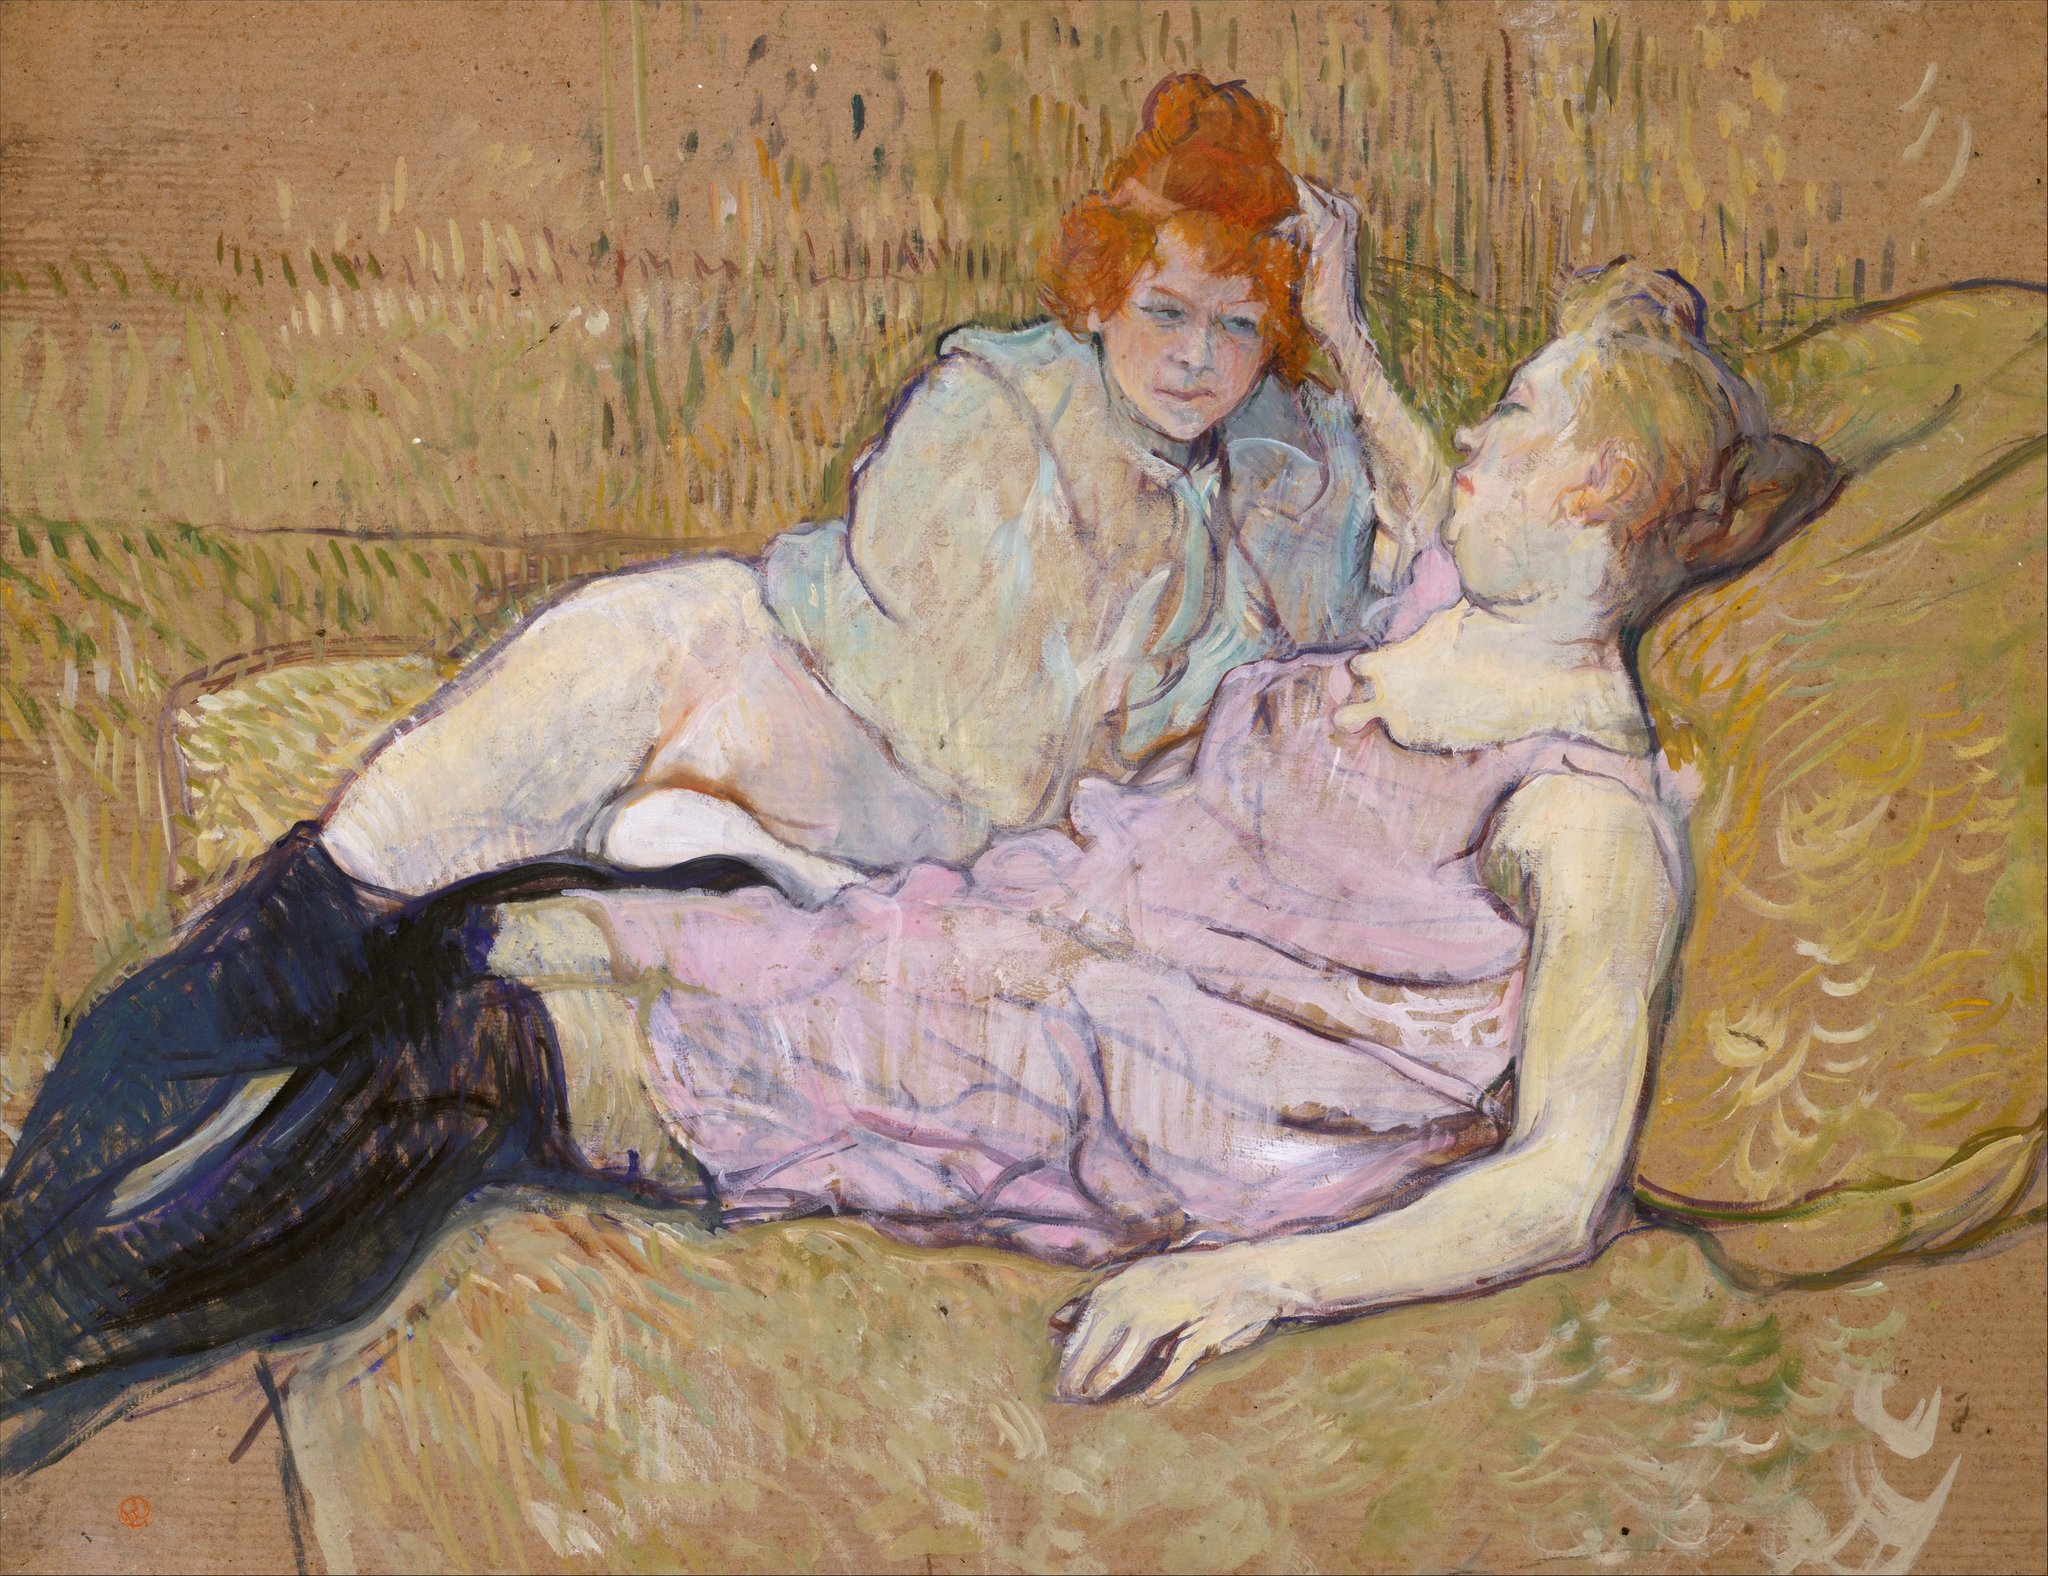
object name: painting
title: The Sofa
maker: henri de toulouse-lautrec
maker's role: artist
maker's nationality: french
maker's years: 1864-1901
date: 1894-1896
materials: cardboard, oil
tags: couples,women,prostitutes